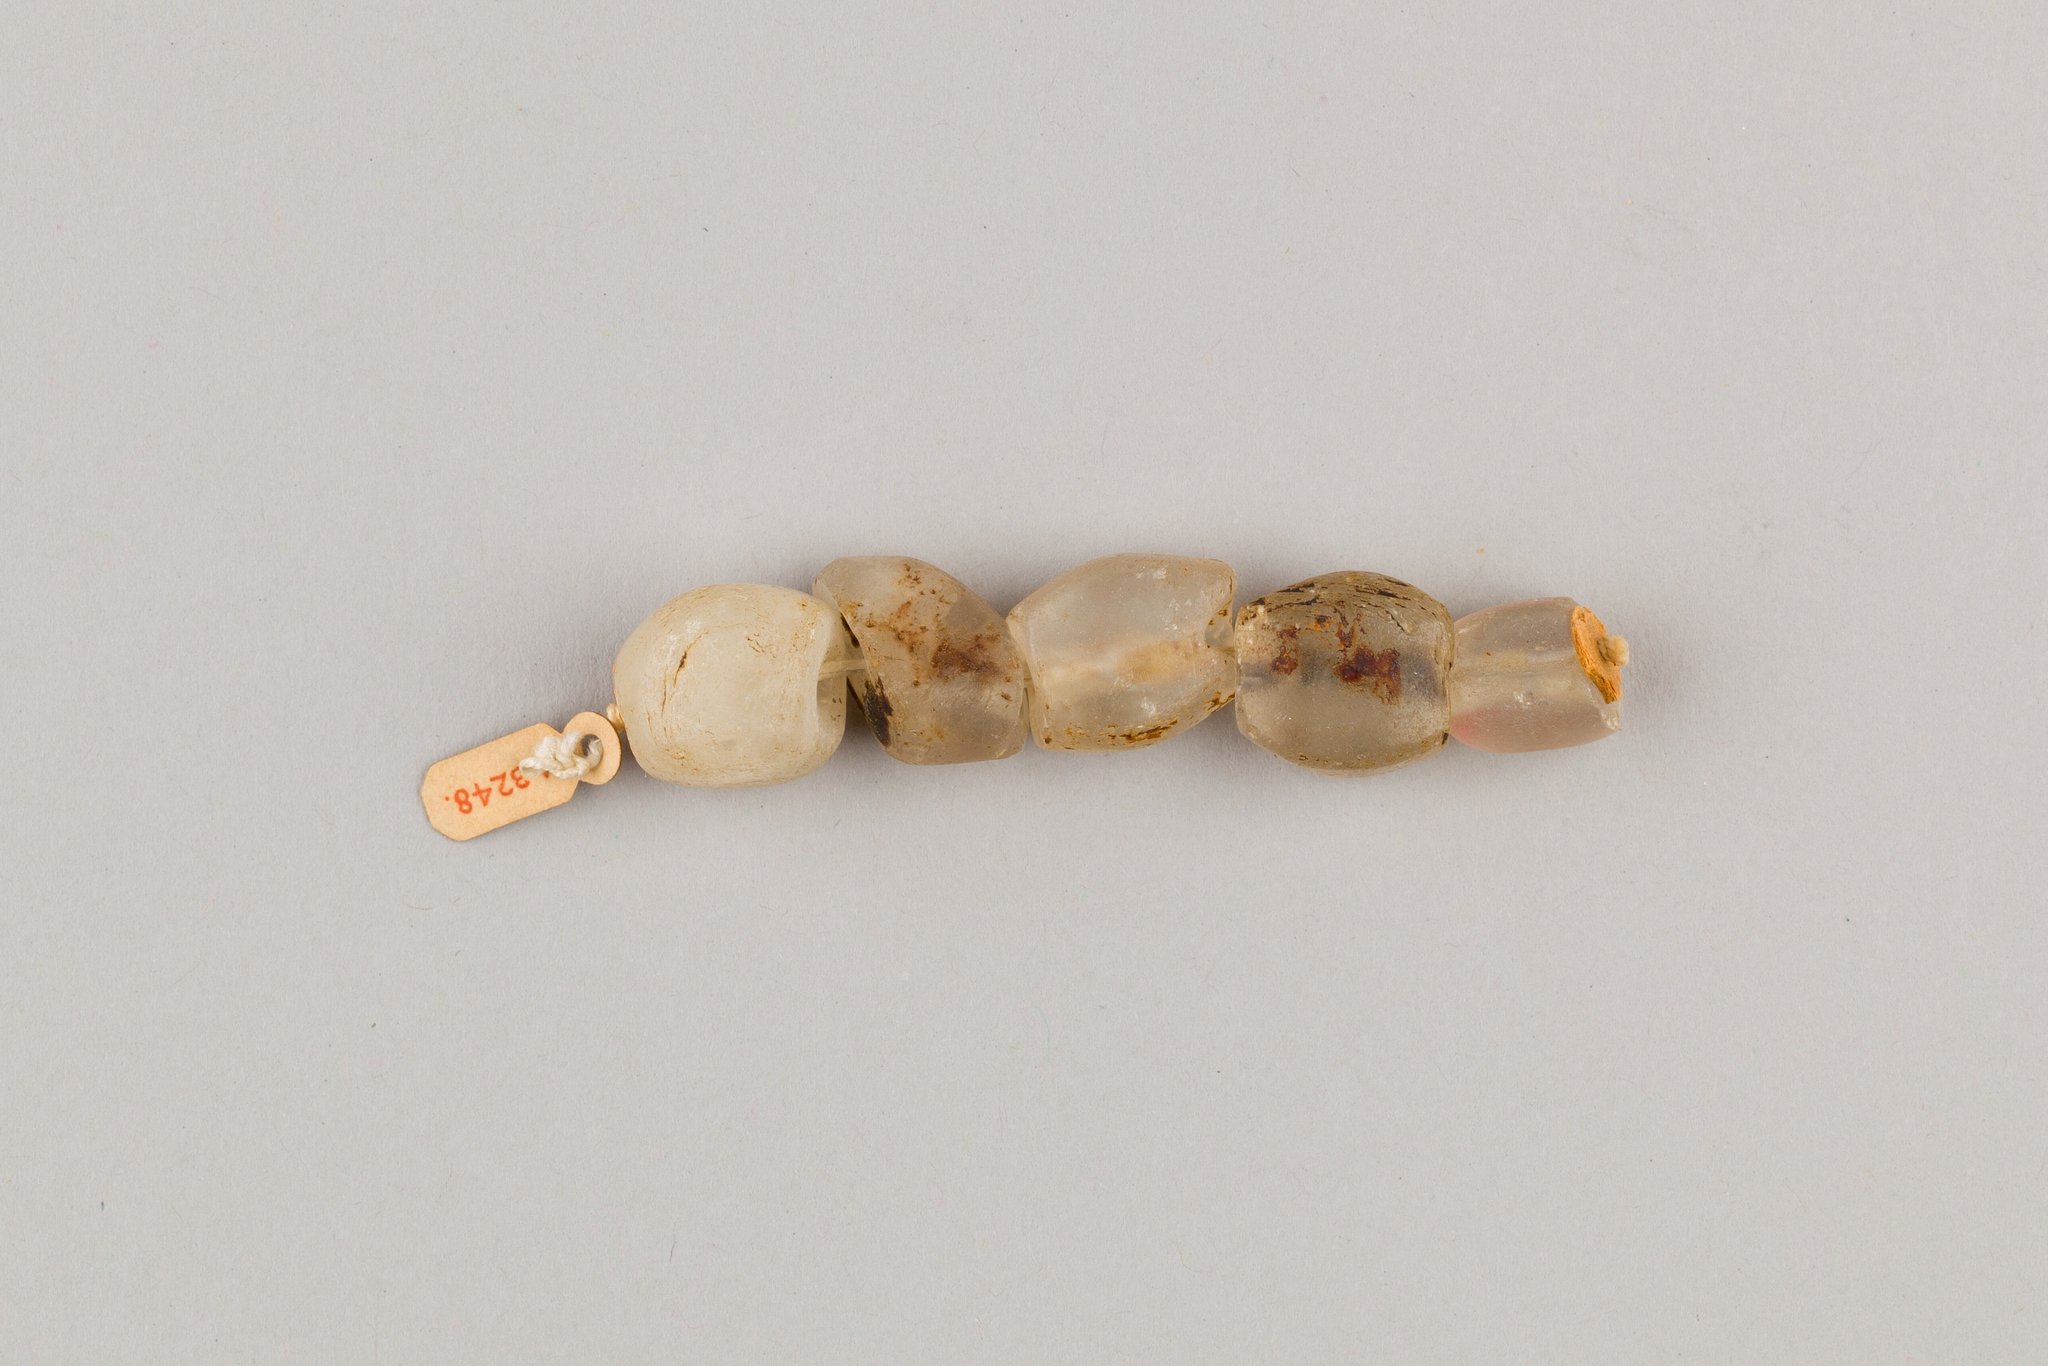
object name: string of 5 bead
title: String of 5 beads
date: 300 BCE-300 CE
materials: quartz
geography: egypt